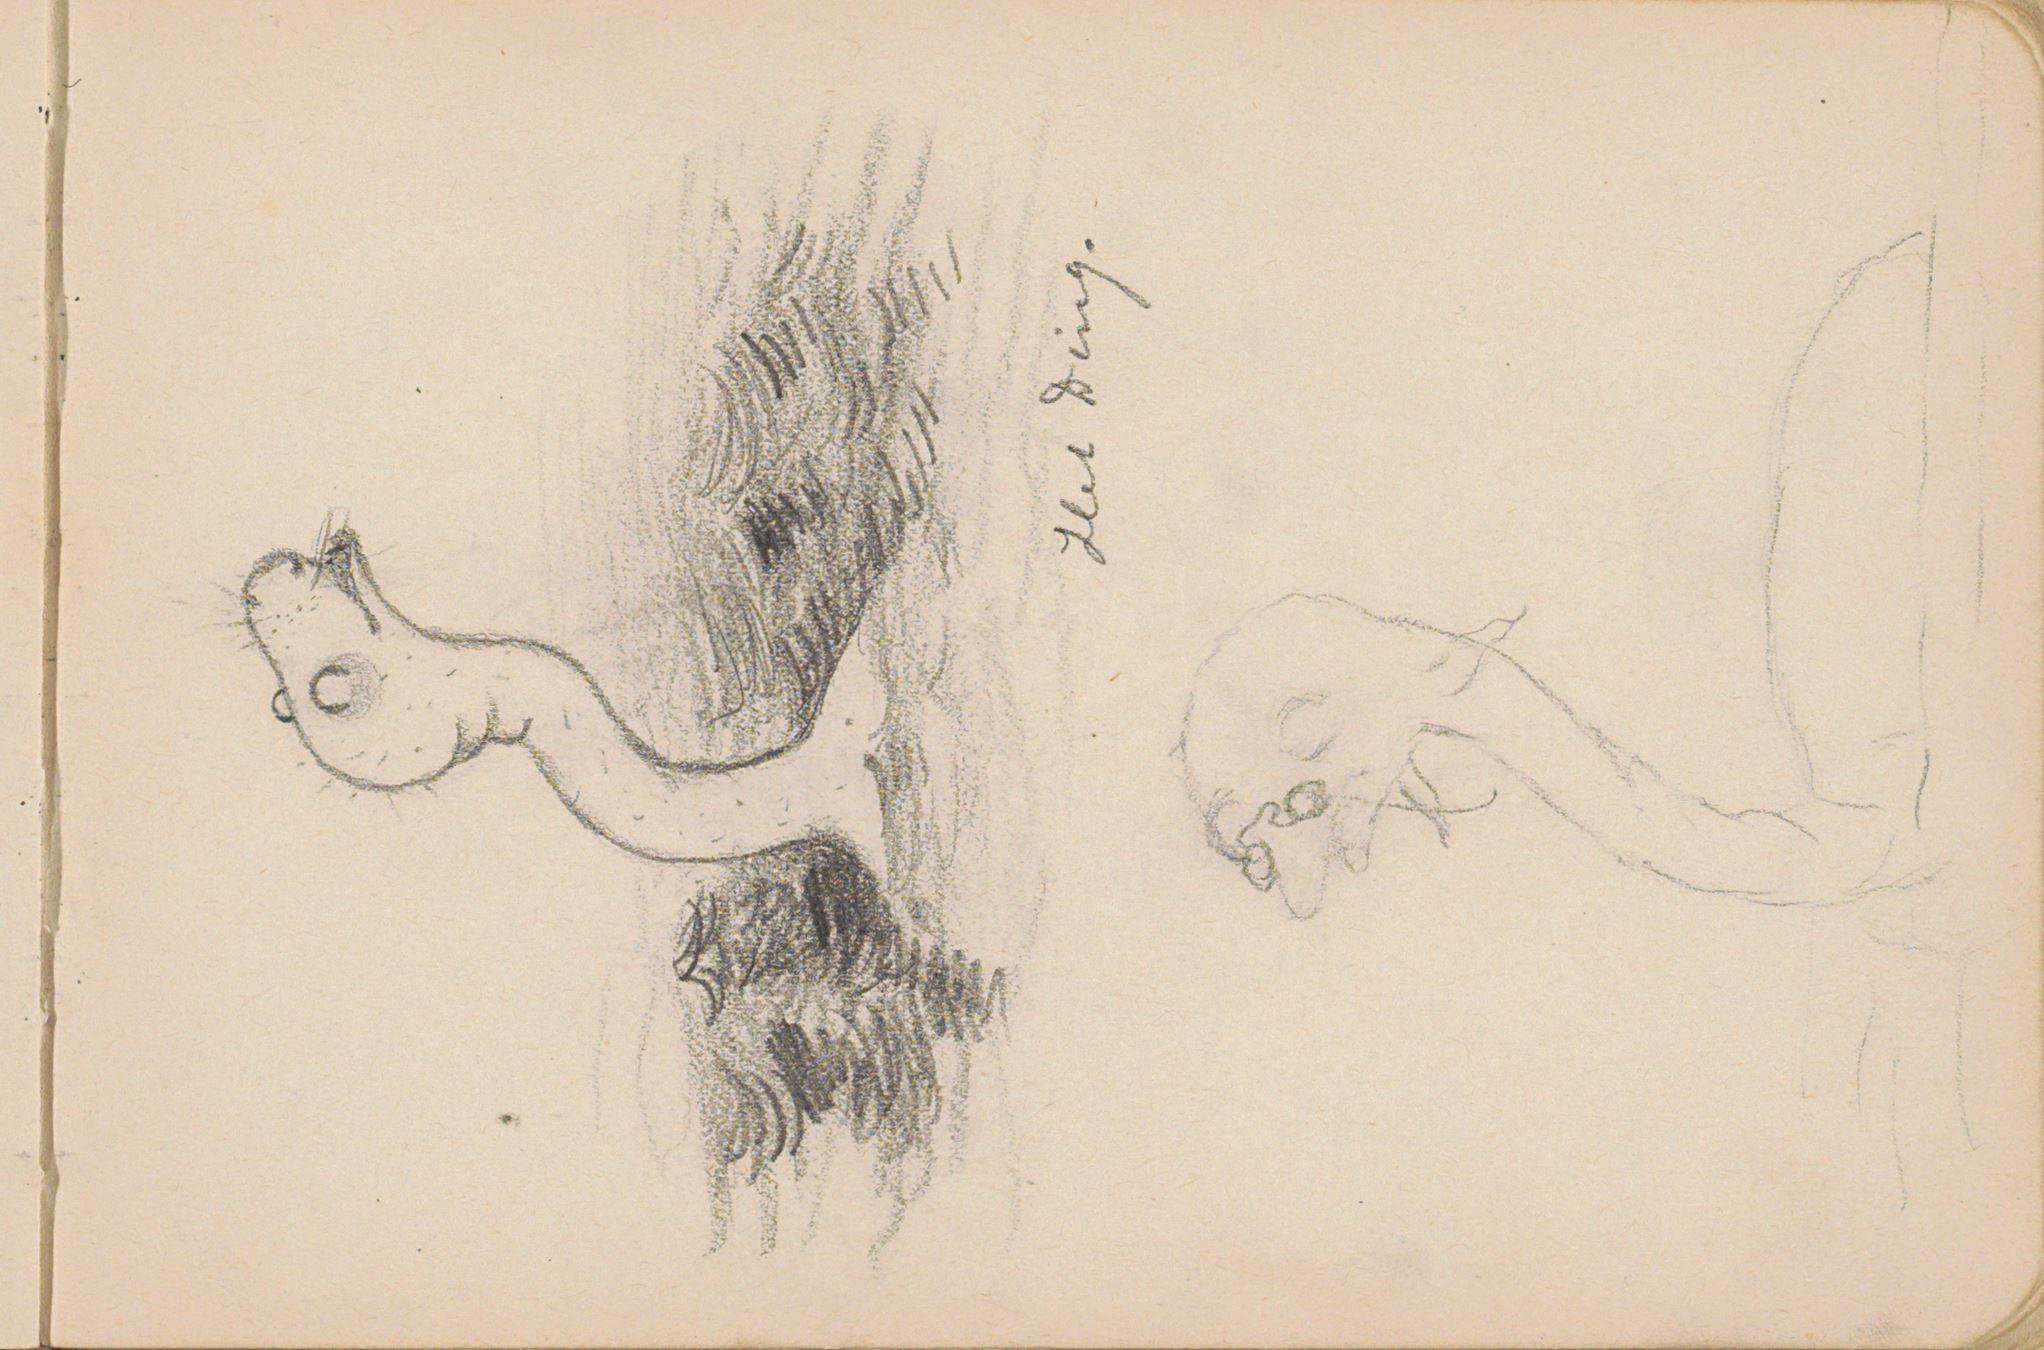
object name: sketchbook leaf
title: Gefantaseerde watermonsters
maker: julie de graag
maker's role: draughtsman, print maker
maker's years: 1877-1924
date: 1894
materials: paper, pencil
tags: monsters ~ animals in general (of undetermined kind)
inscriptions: annotation: ‘Het Ding.’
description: Blad 15 recto uit een schetsboek met 35 bladen.